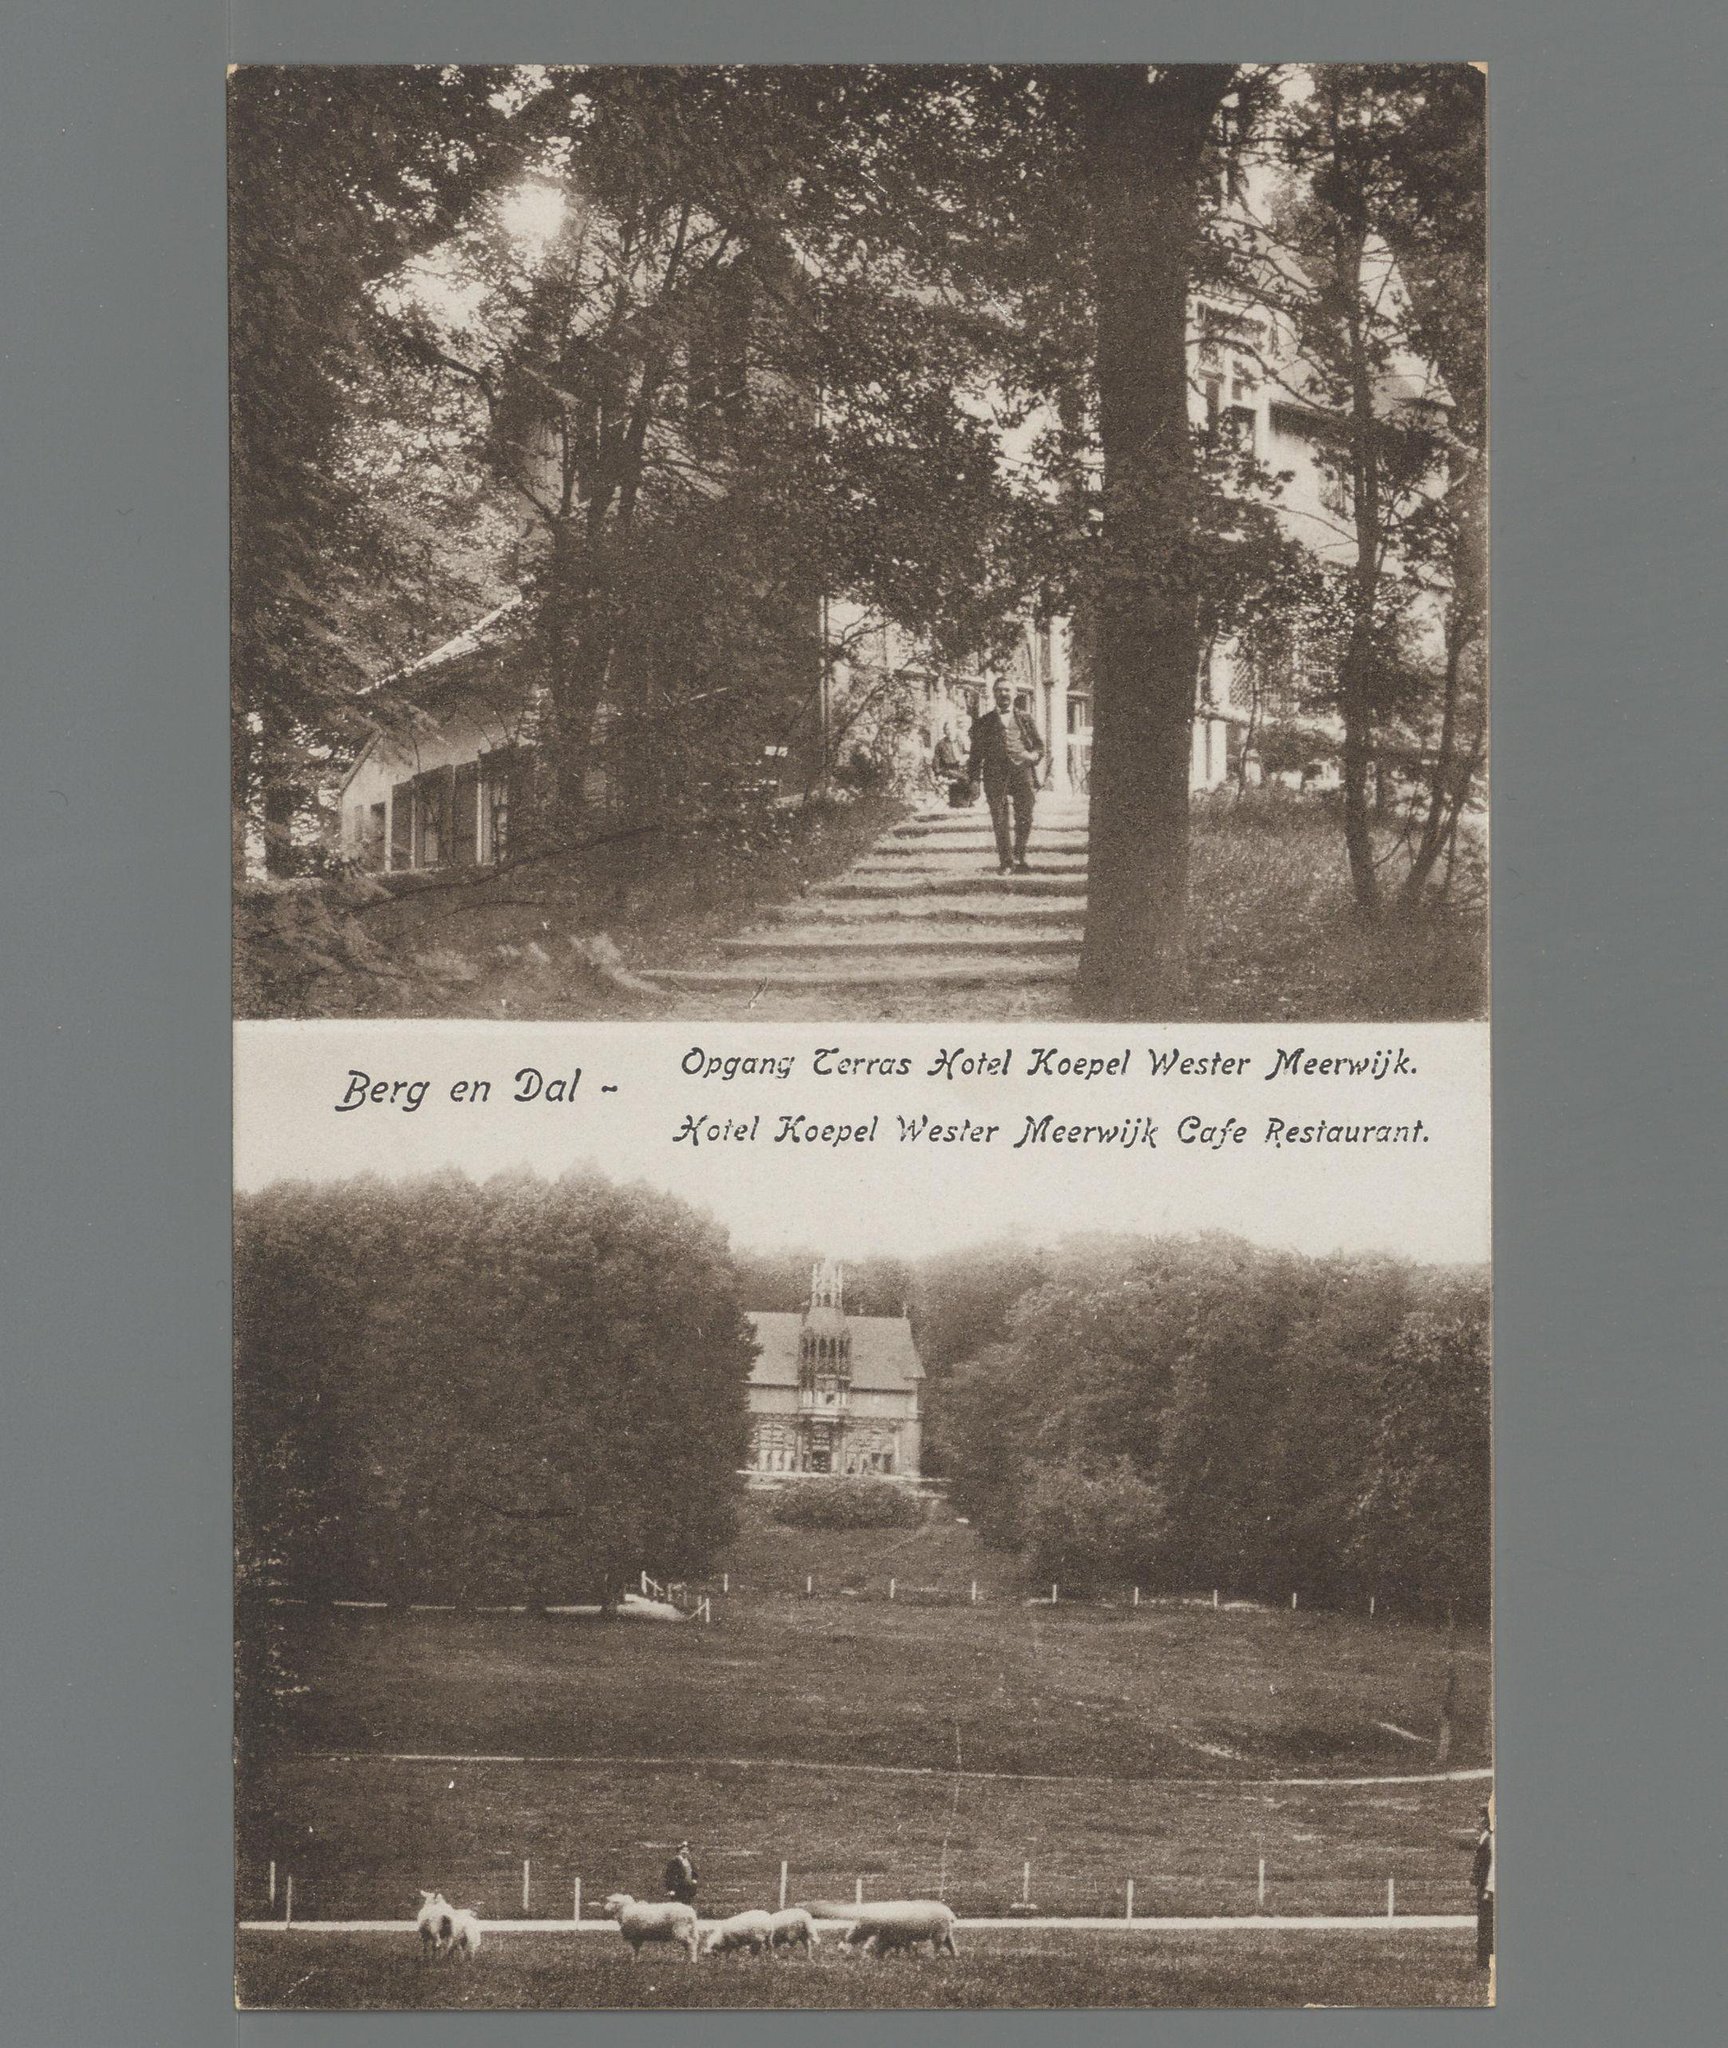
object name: ansichtkaart, prentbriefkaart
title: Berg en Dal - Opgang terras Hotel Koepel Wester Meerwijk. Hotel Koepel Wester Meerwijk Cafe Restaurant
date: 1905-1930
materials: cardboard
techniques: photograph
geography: nijmegen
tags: gate, entrance, hotel, hostelry, inn